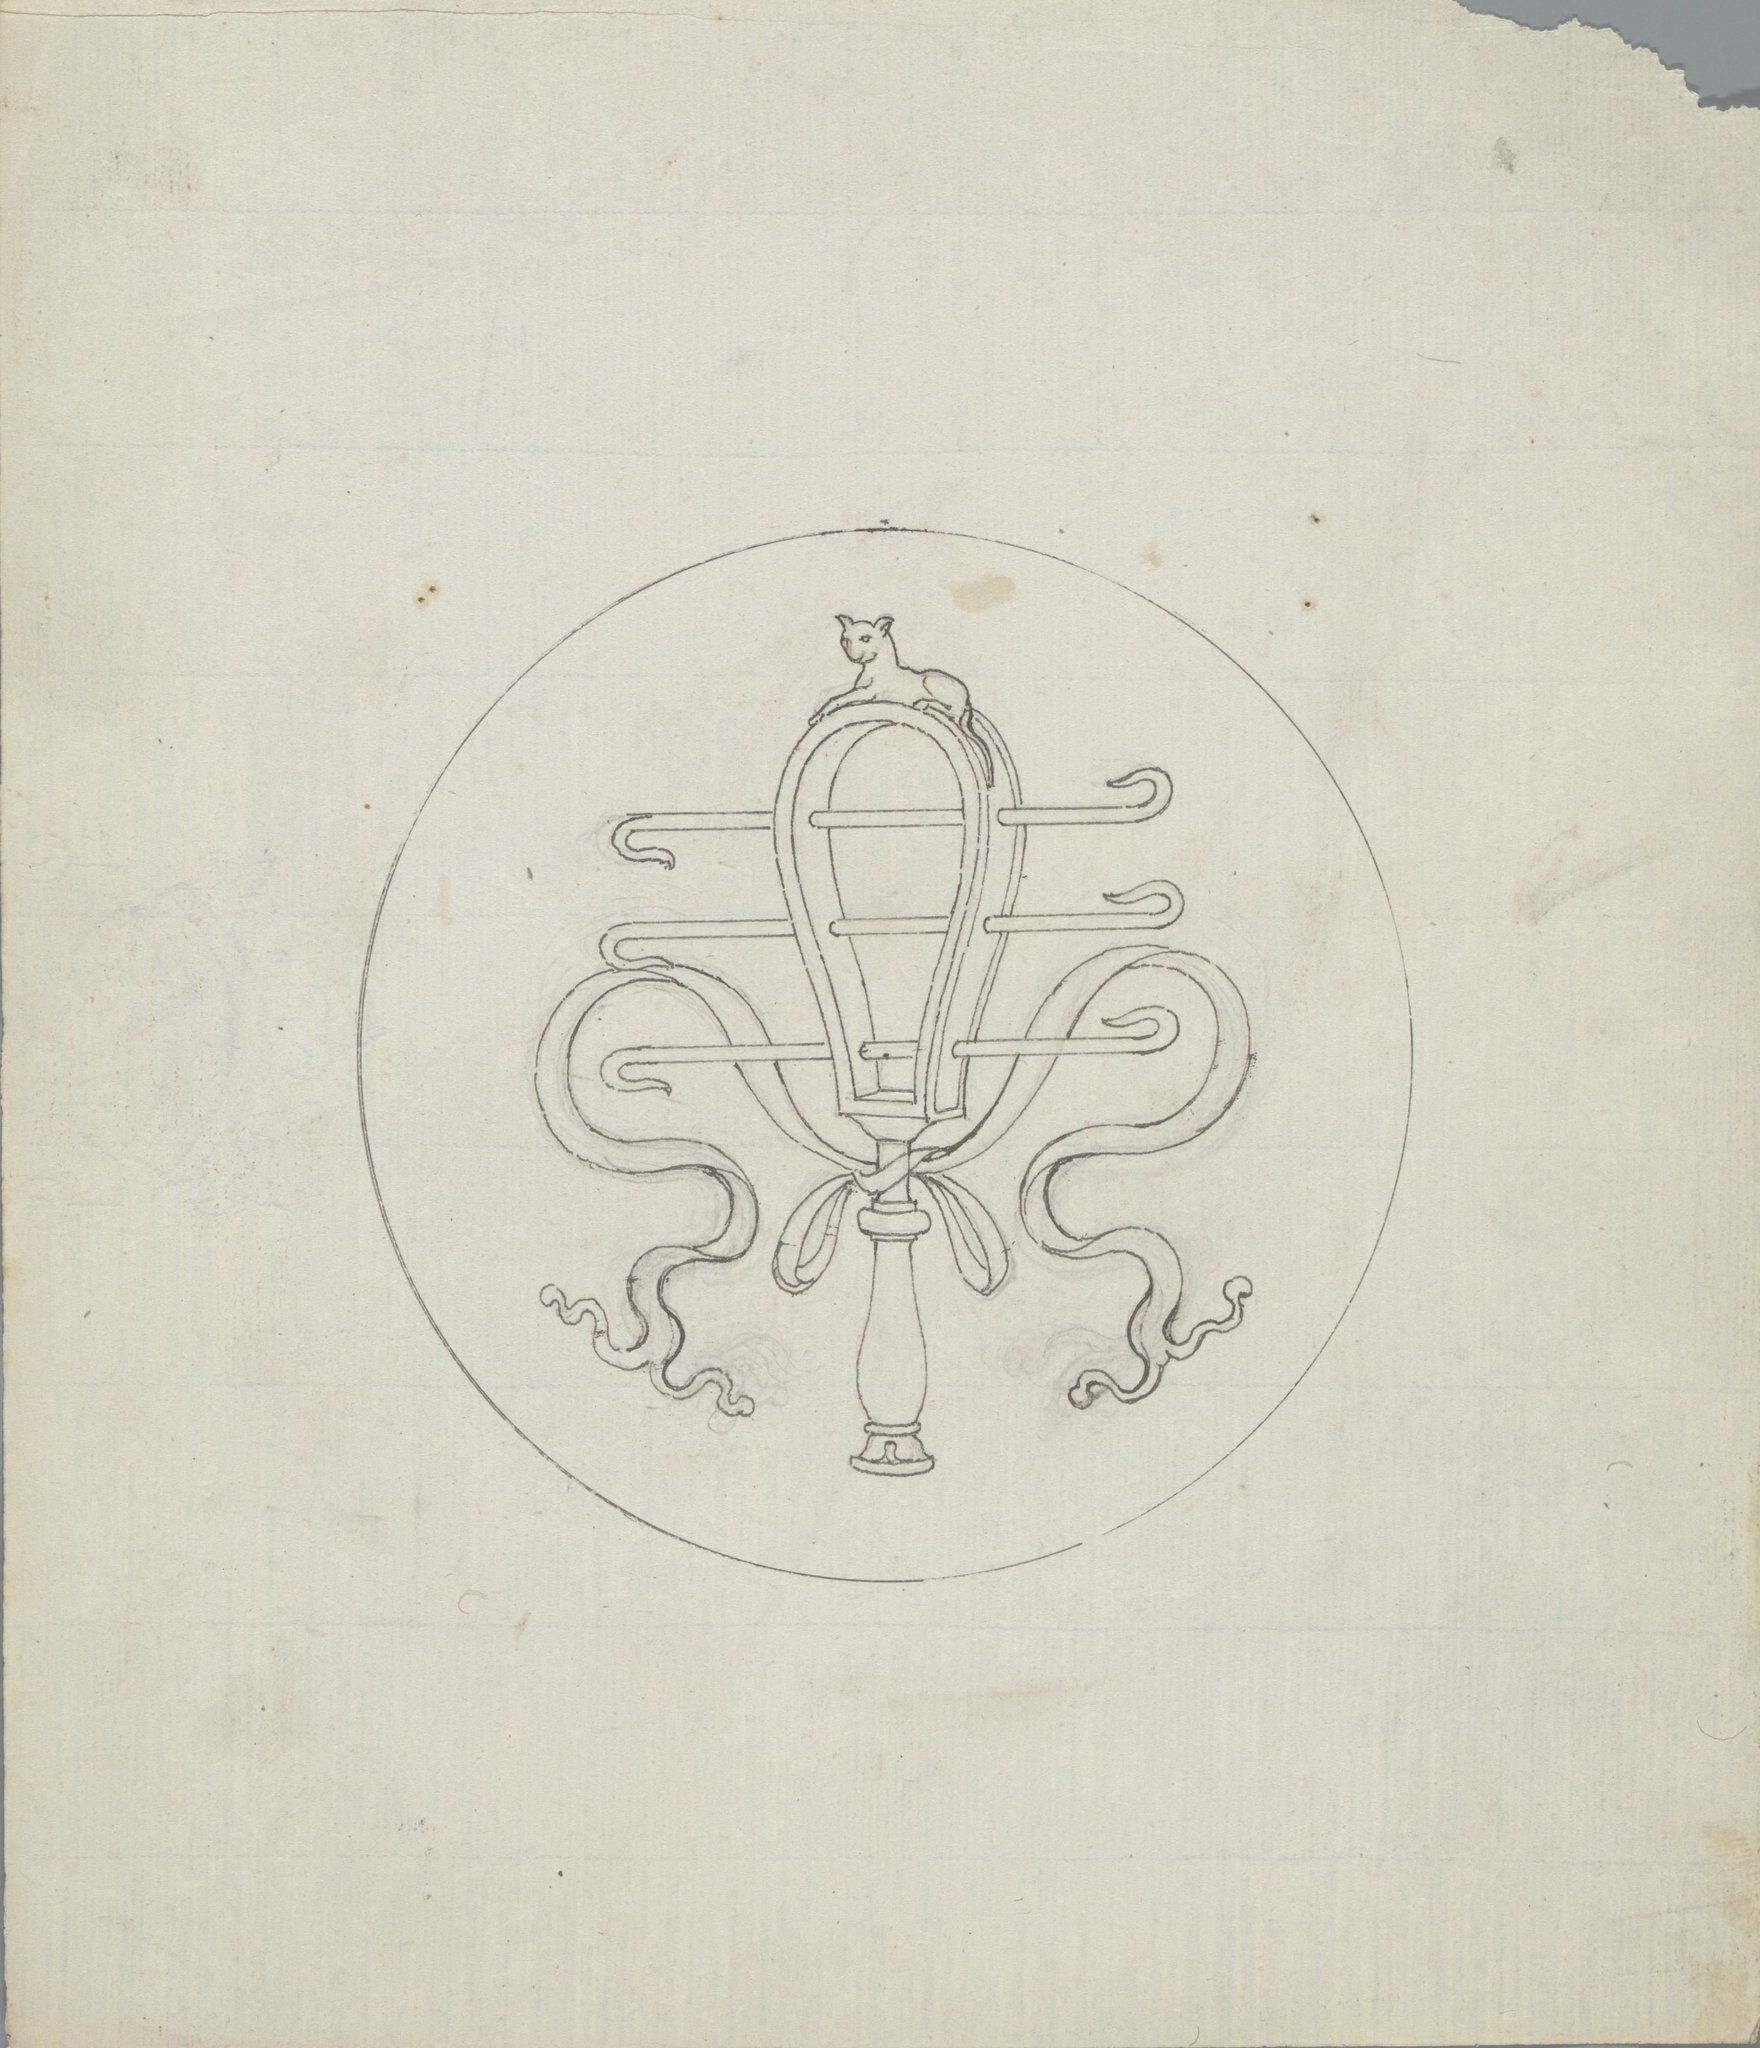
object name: design drawing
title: Door katachtig dier bekroond instrument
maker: pierre félix van doren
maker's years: 1797-1856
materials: graphite, ink, paper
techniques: pen in black ink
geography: brussels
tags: musical instruments; group of musical instruments, trophy, i.e.: decorative arrangement of symbolic or typical objects ~ ornament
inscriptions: watermark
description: Een van 103 ontwerpen voor marqueterie van aan linten opgehangen muziekinstrumenten in ronde medaillons, bestemd voor de set stoelen gemaakt door Van Doren voor de grote zaal van het Paleis van de Prins van Oranje in Brussel in 1828.